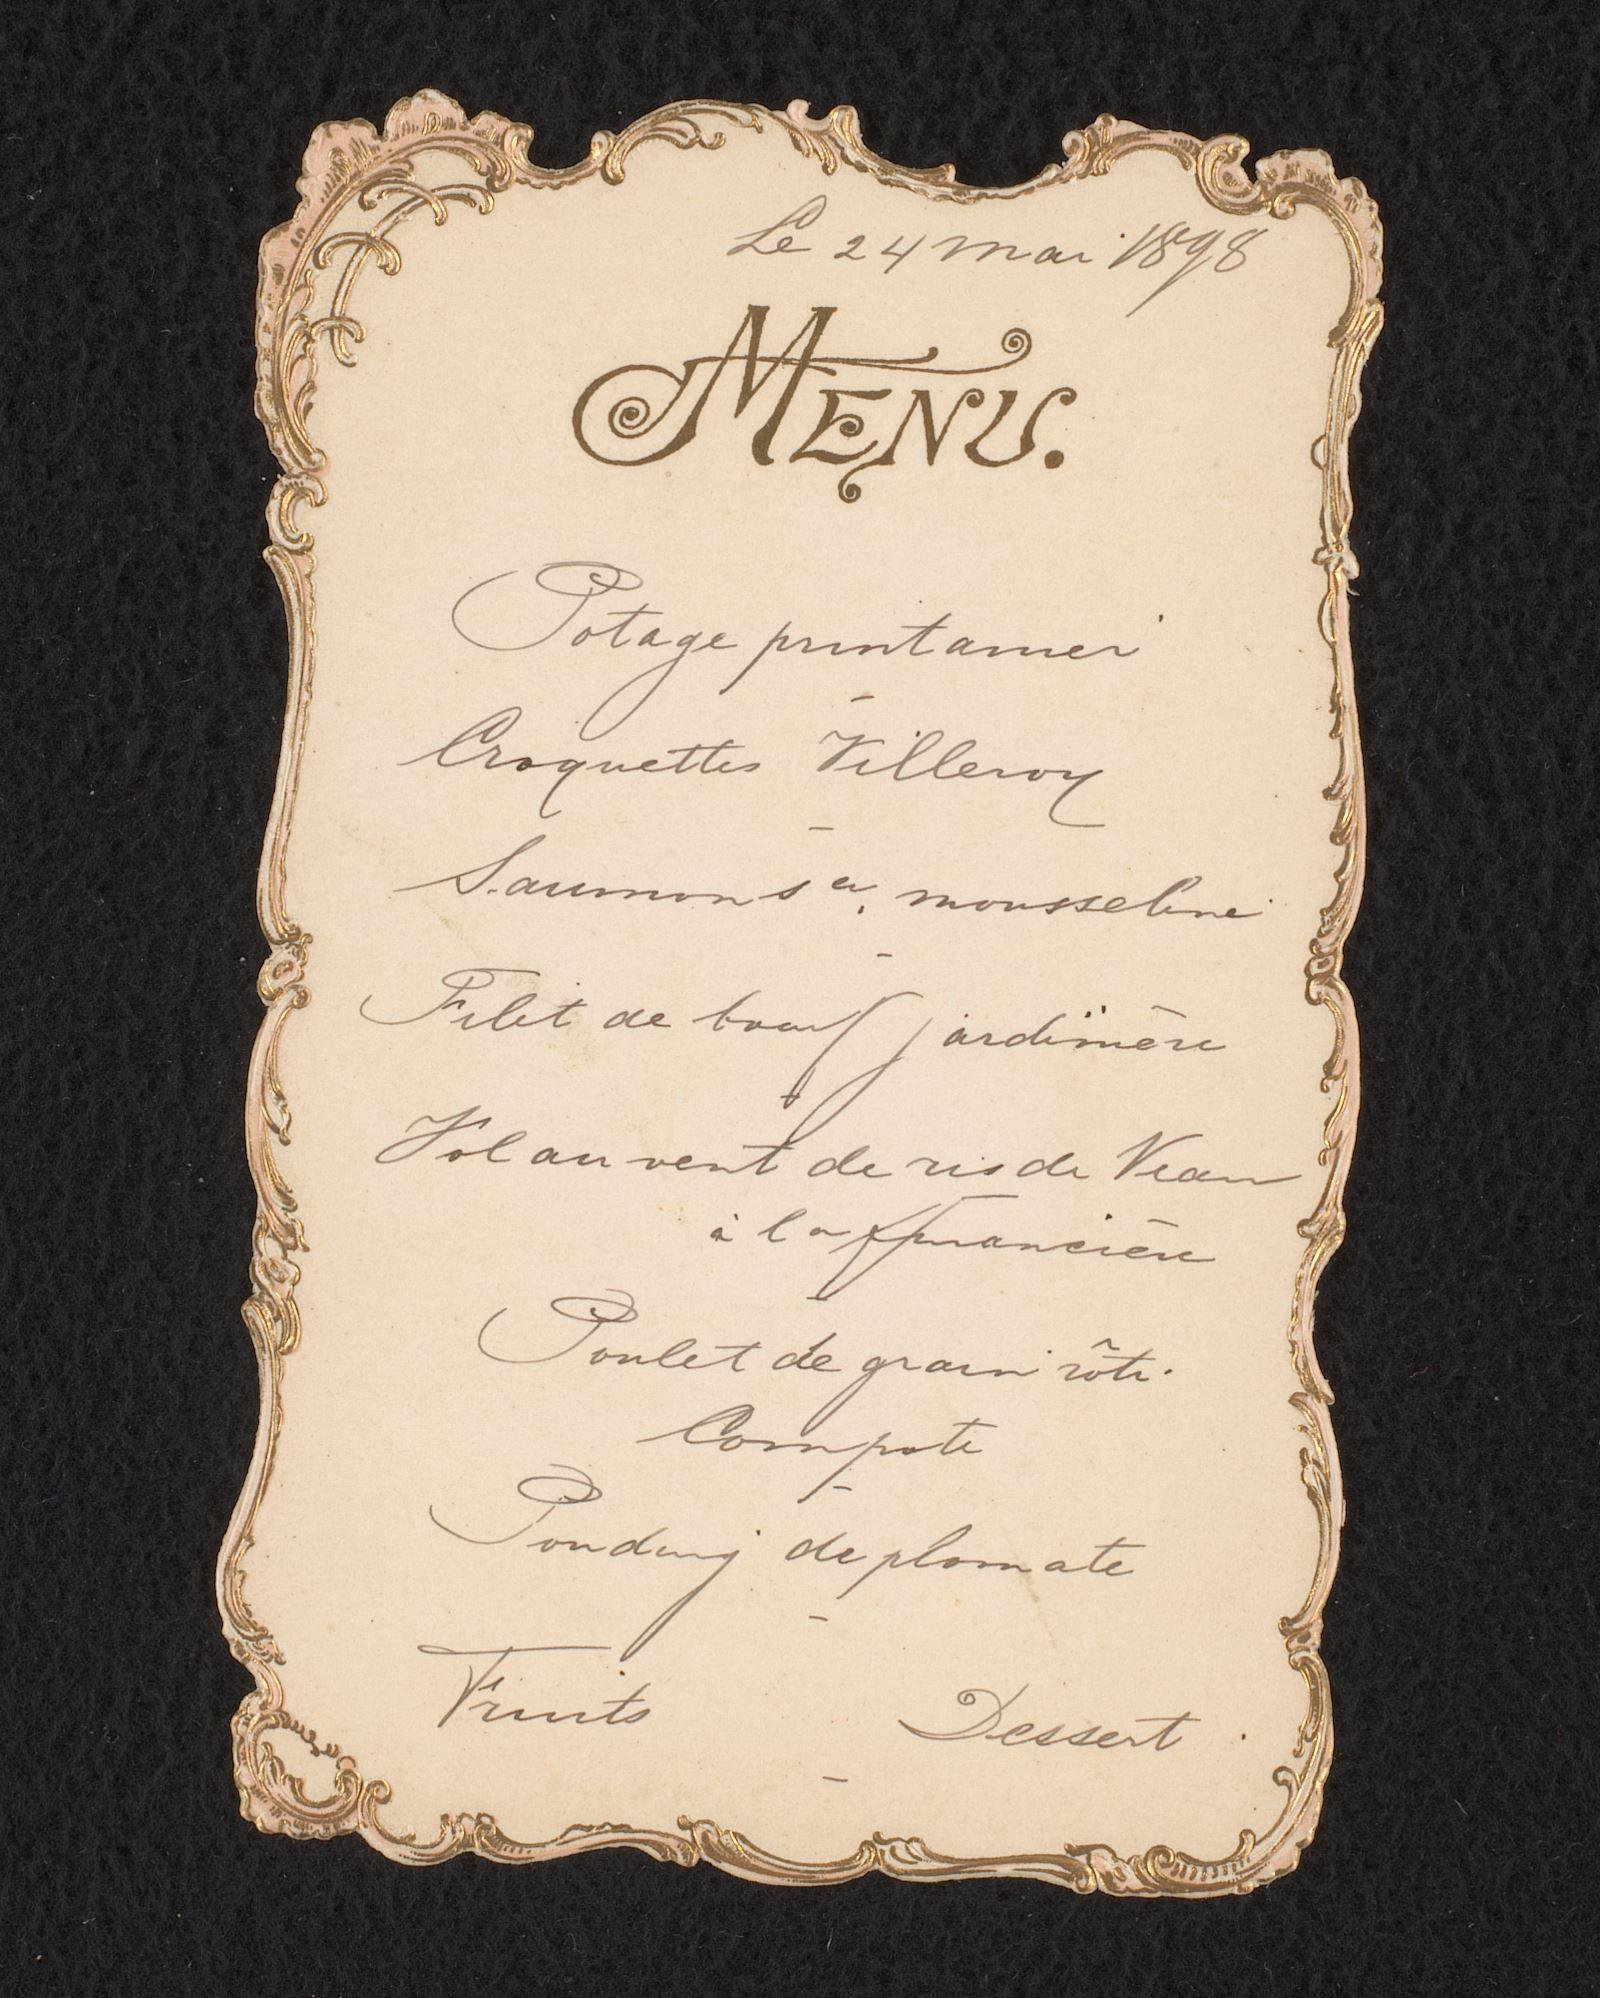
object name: text sheet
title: Menukaart voor een diner op 24 mei 1898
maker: Anonymous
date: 1898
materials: paper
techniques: blind stamped, chromolithography, pen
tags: 43b311(+12)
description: Bij gebrek aan gegevens over de vervaardiger is voor de bepaling van de rechten van dit object gebruik gemaakt van de vervaardigingsdatum.